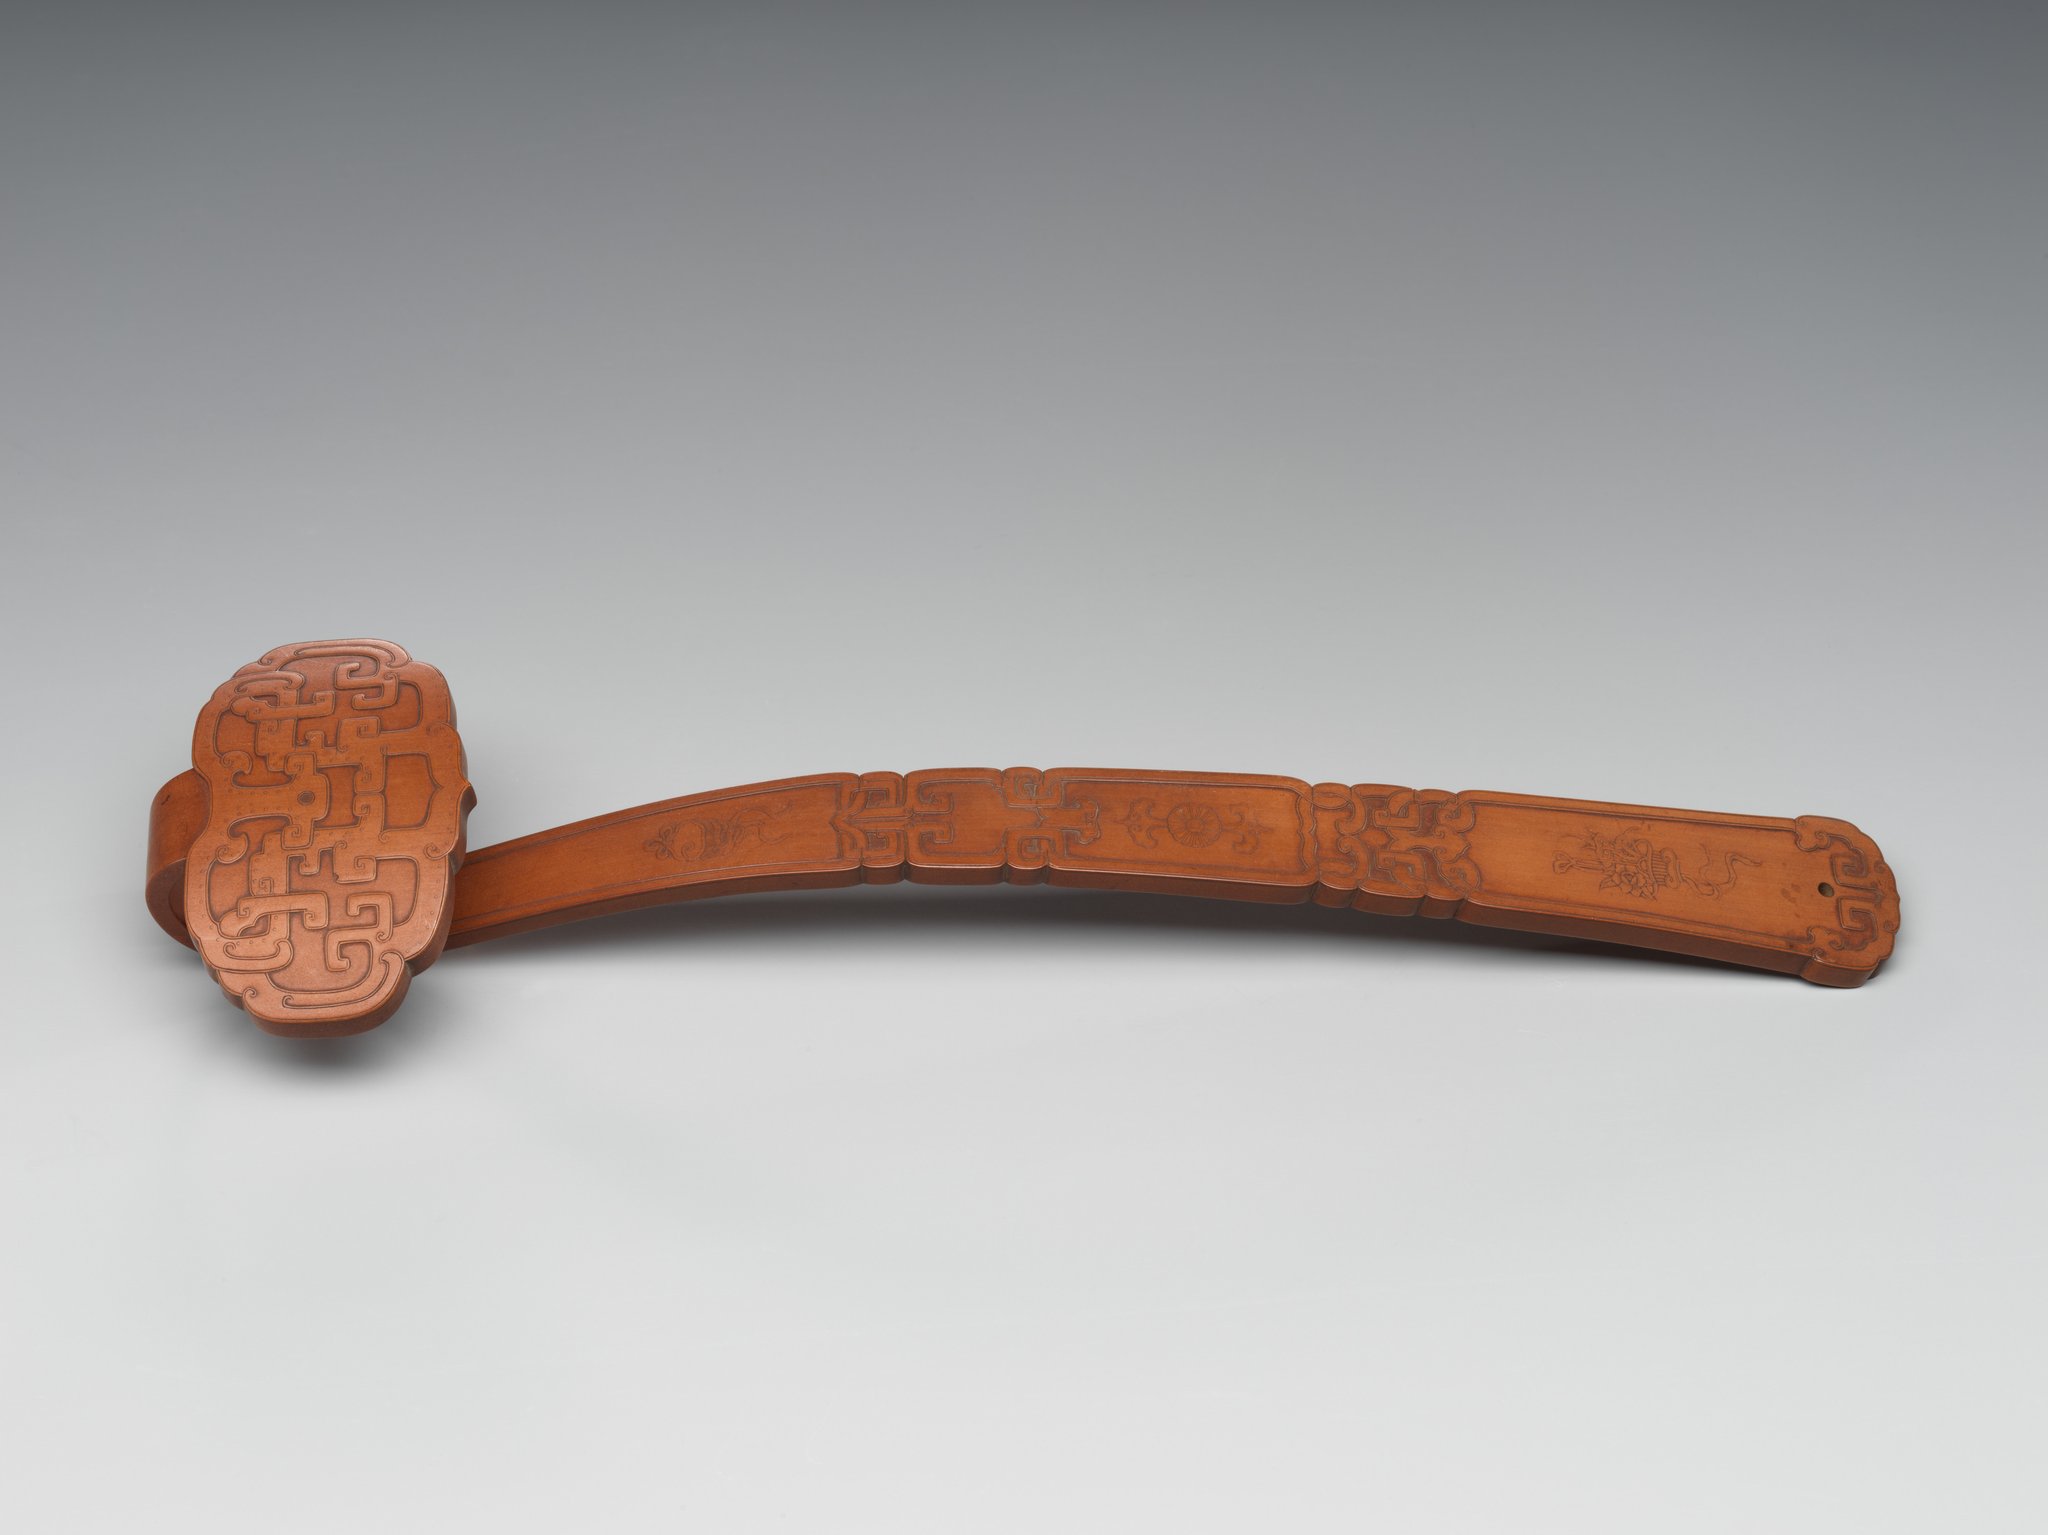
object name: scepter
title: Ruyi scepter with poem composed by the Qianlong Emperor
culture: chinese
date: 1736-1795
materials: bamboo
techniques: veneering